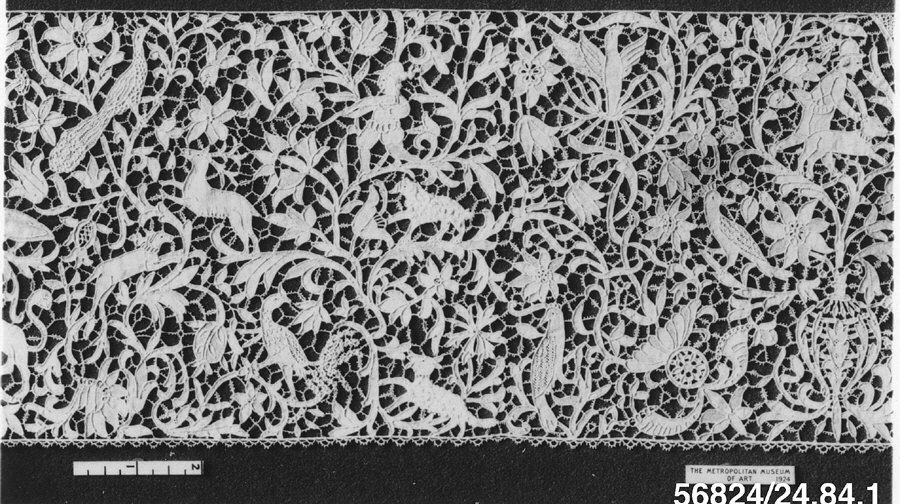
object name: flounce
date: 1801-1900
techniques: lace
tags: human figures,peacocks,deer,flowers